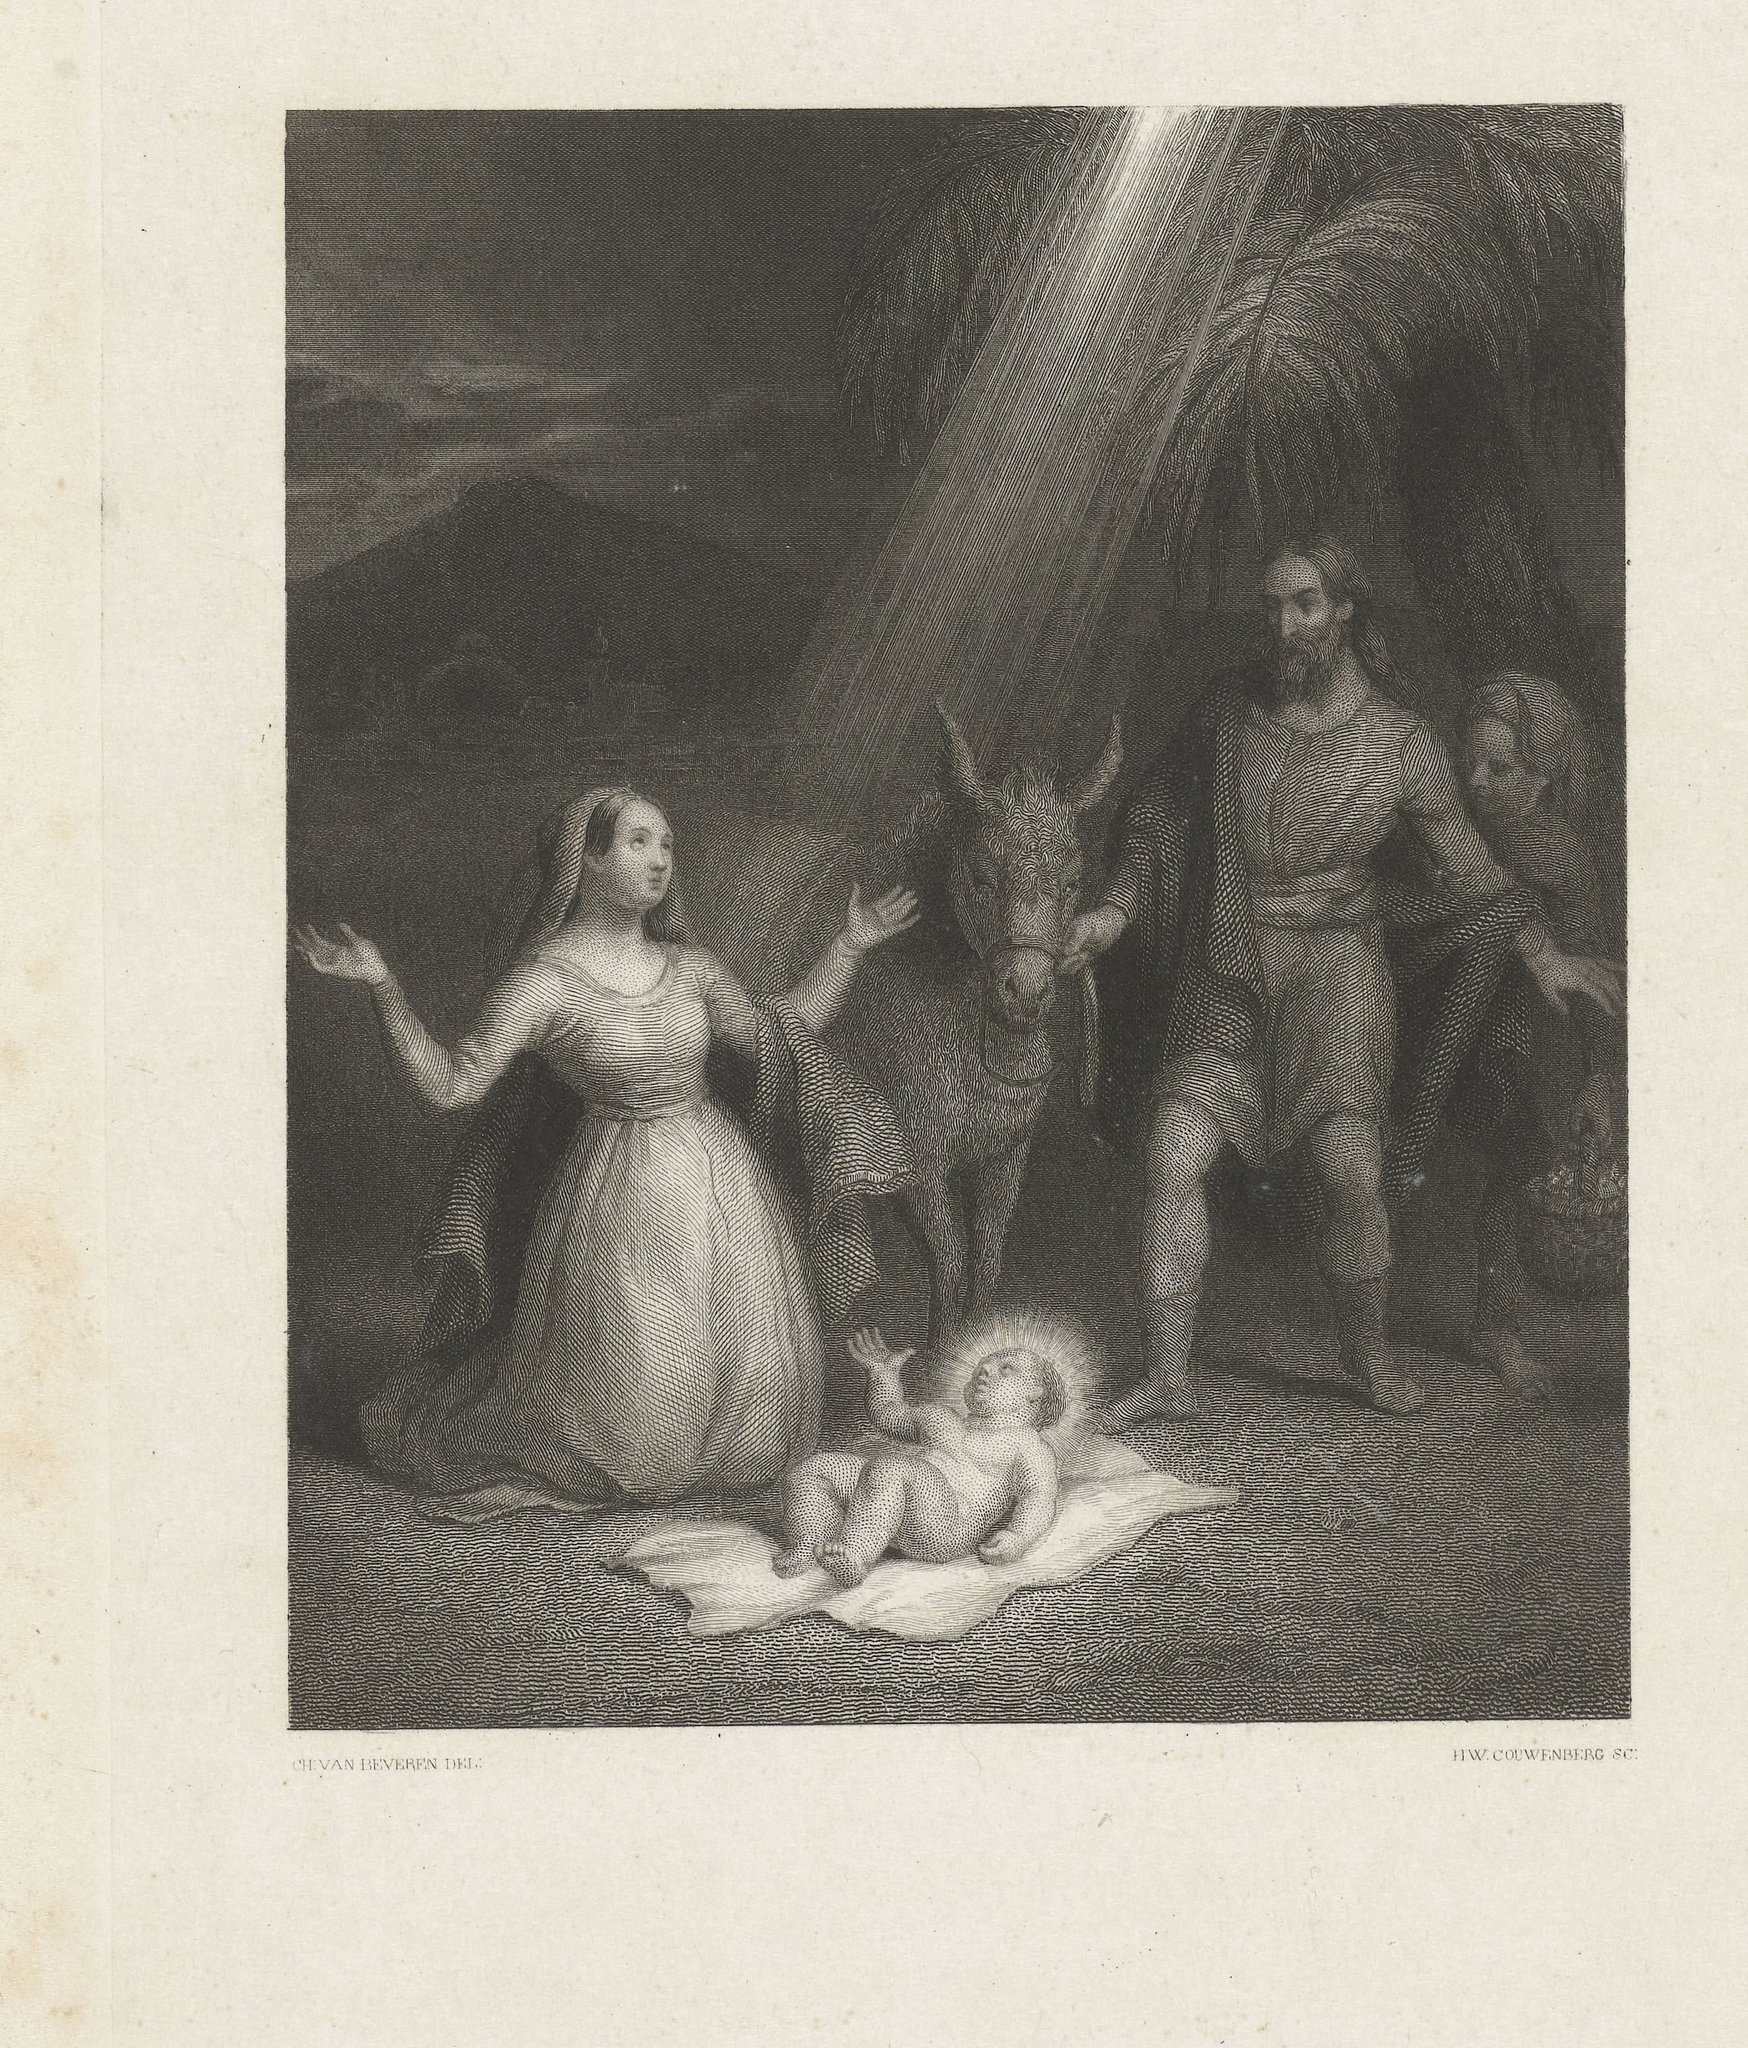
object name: book illustration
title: Geboorte van Christus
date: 1830-1845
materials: paper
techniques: engraving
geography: amsterdam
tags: adoration of the christ-child by mary and joseph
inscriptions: collector's mark: Lugt 2228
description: Maria knielt biddend naast het Kind, dat op een doek op de grond ligt. Licht straalt vanuit de hemel op haar en het Kind. Naast Maria staat Jozef met de ezel. Een herder kijkt over Jozefs schouder naar het Kind.